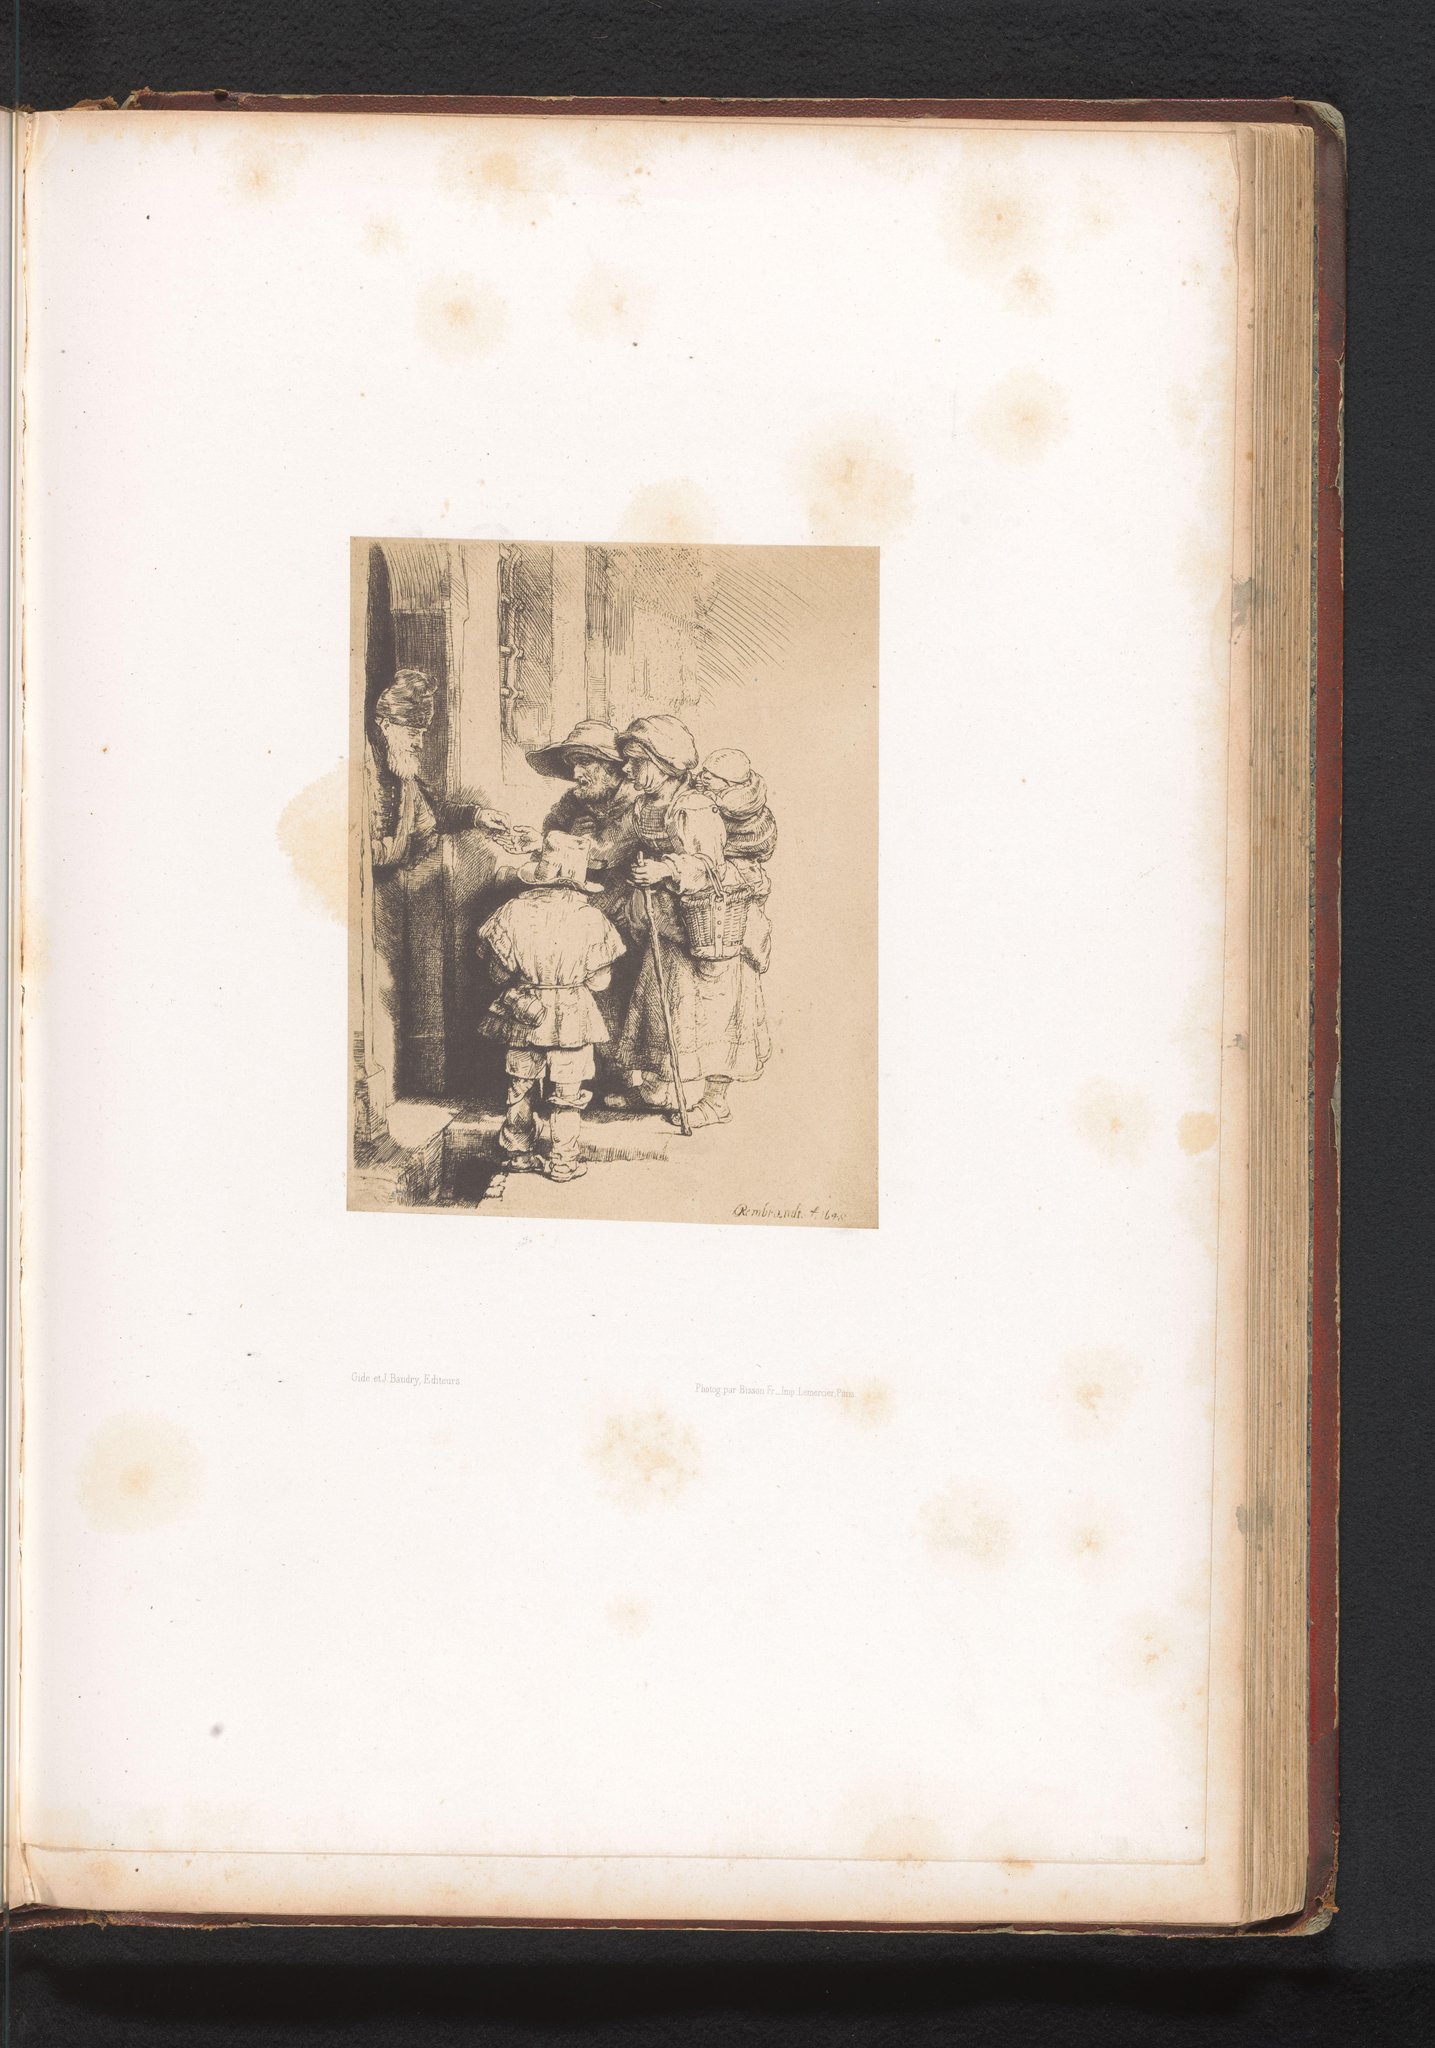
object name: photograph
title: Fotoreproductie van een ets van bedelaars door Rembrandt van Rijn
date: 1848-1853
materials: photographic support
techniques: salted paper print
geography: paris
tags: beggar